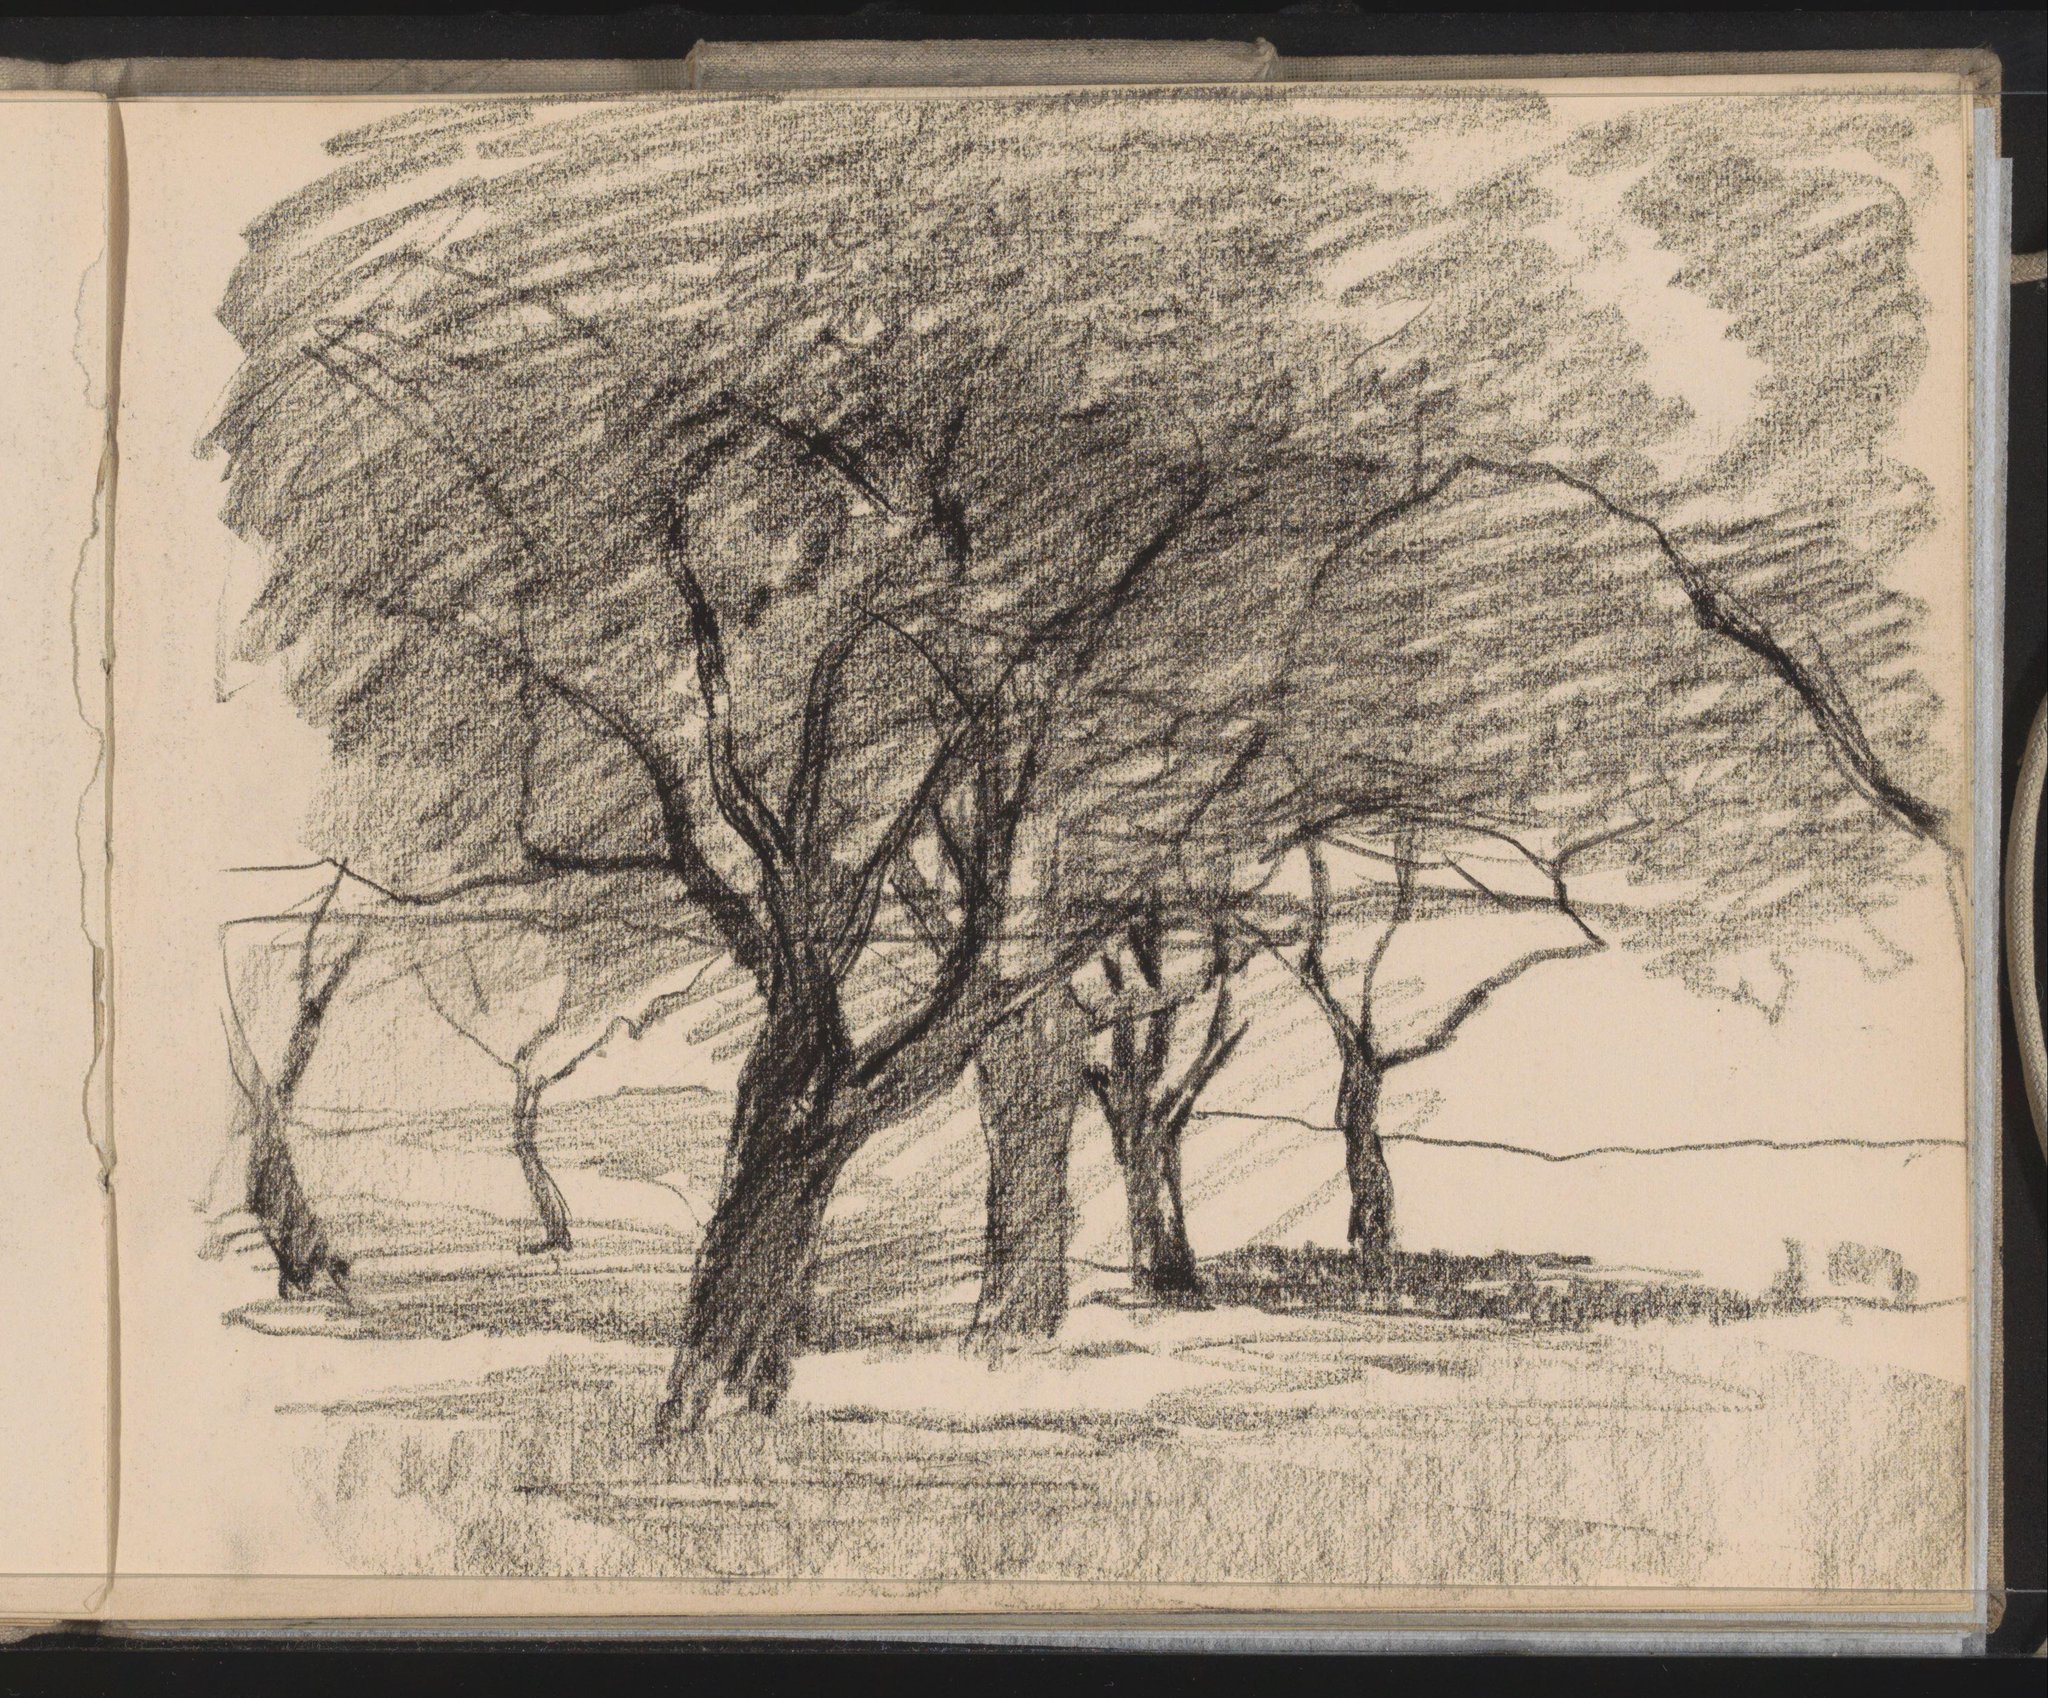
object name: sketchbook leaf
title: Landschap met bomen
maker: willem witsen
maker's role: draughtsman, painter, print maker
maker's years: 1860-1923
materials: chalk, paper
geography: wijk bij duurstede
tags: trees, landscapes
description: Pagina 25 uit een schetsboek met 43 bladen.